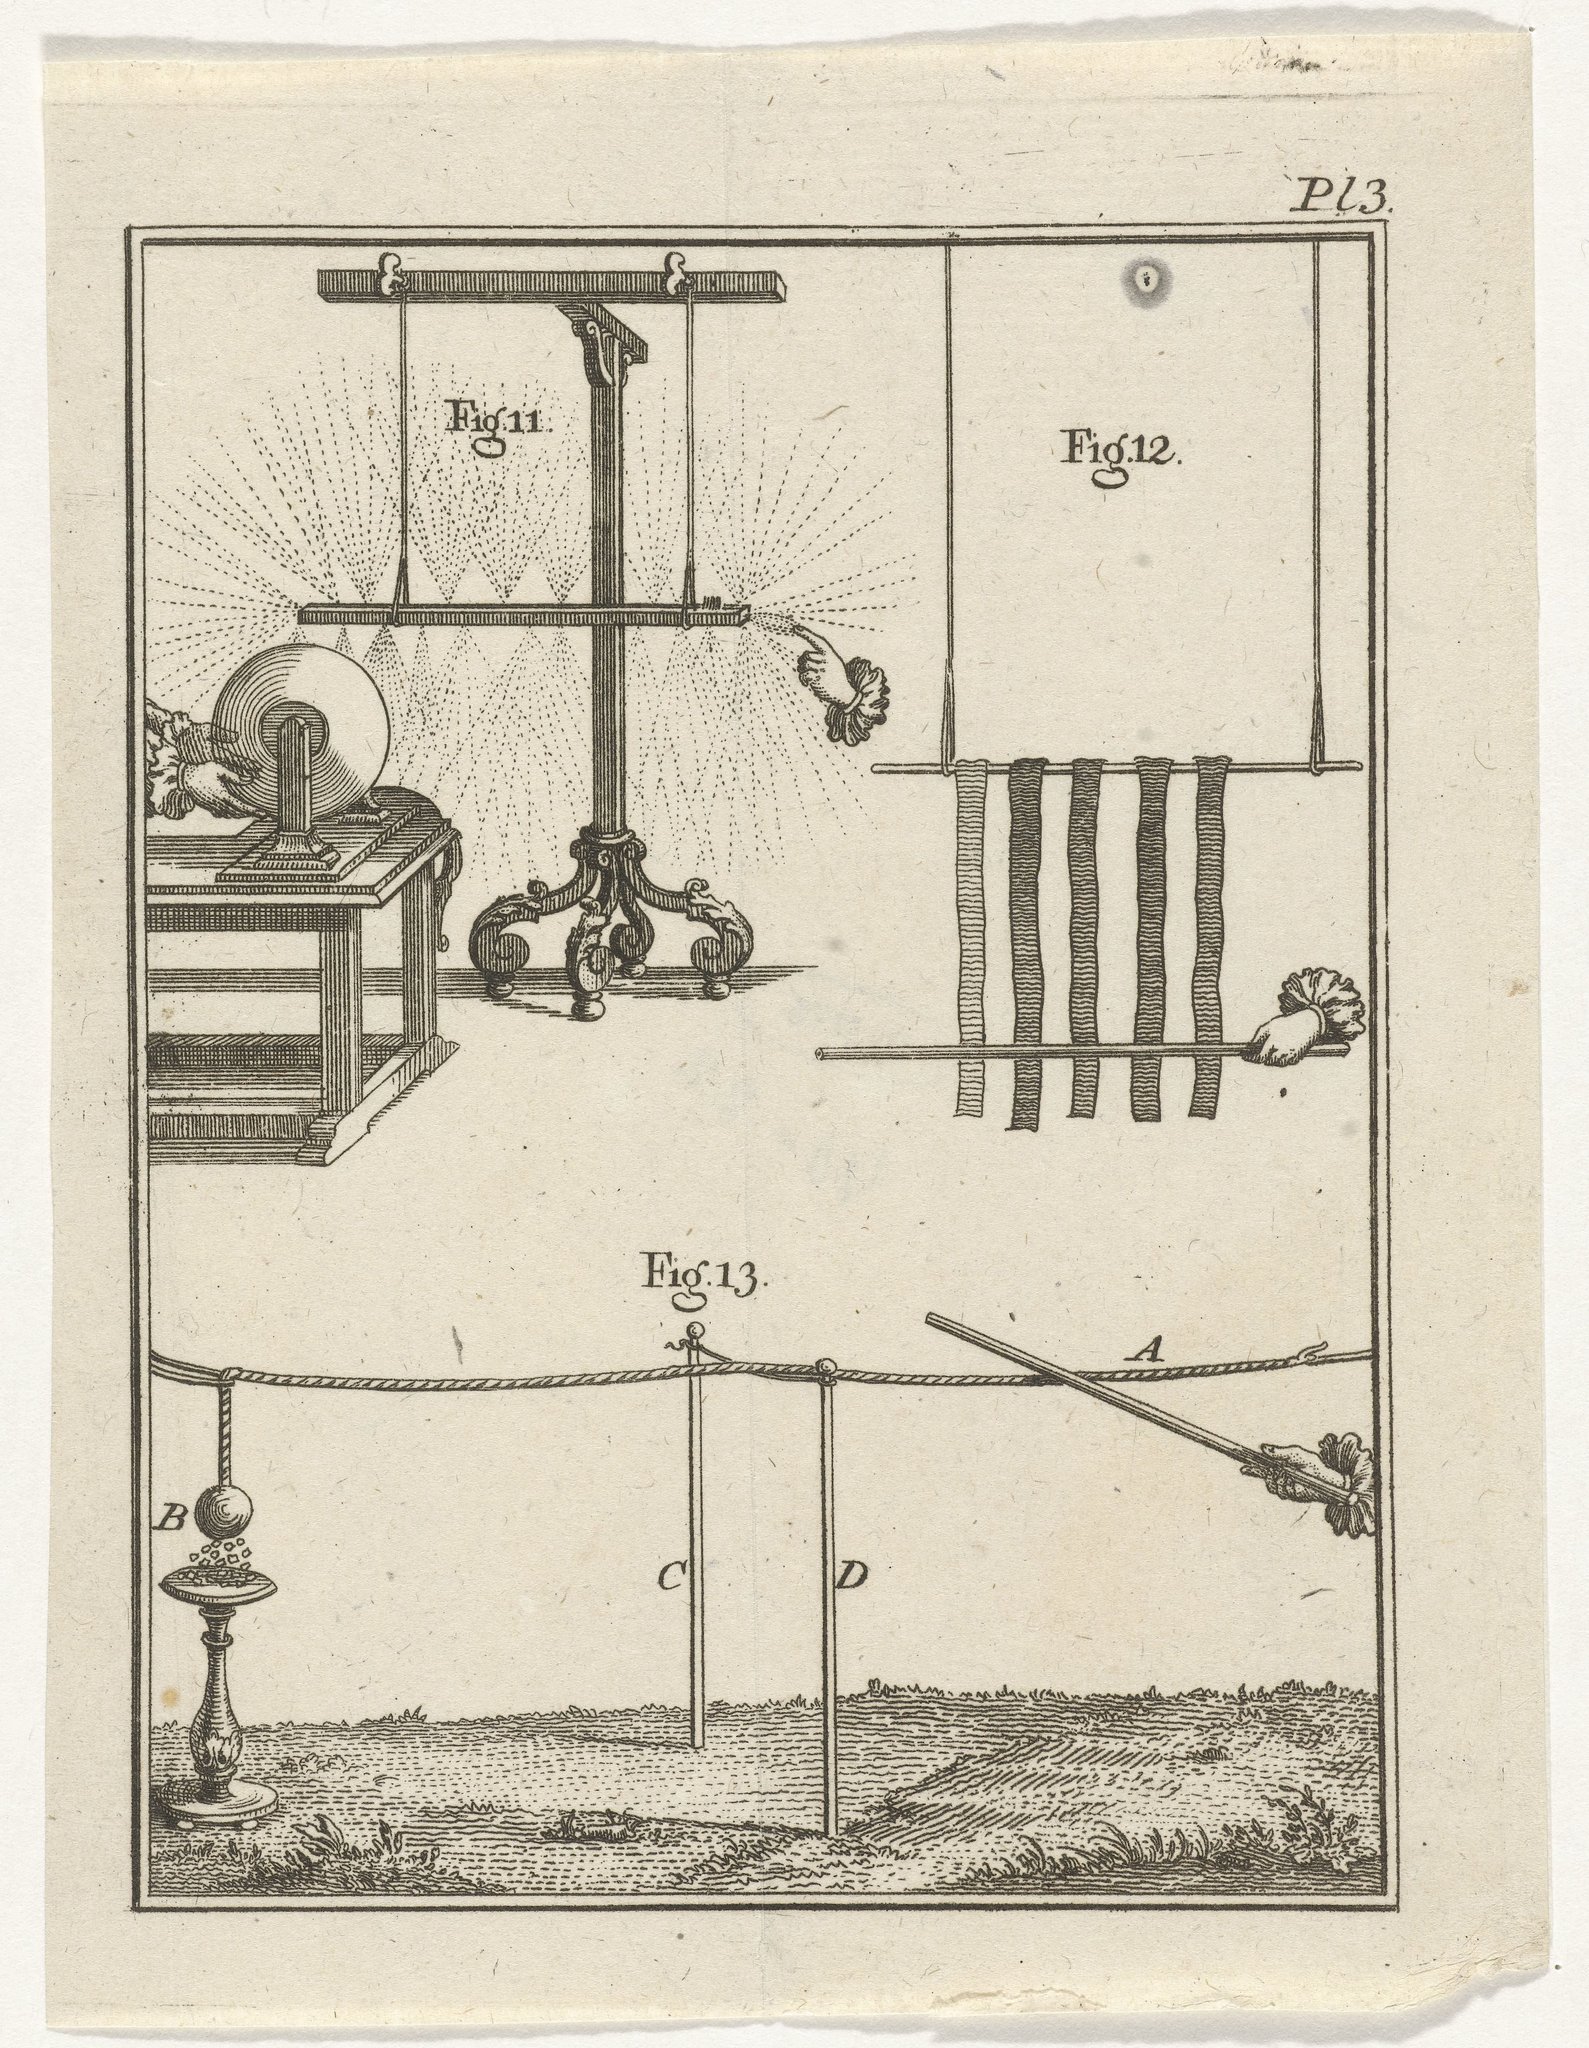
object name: print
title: Natuurkundige instrumenten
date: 1759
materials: paper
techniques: etching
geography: amsterdam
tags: physics (+ tools, instruments; laboratory equipment ~ scientific research)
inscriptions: collector's mark: Lugt 2228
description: Illustratie voor: Nollet, Jean Antoine. Natuurkundige lessen, door proefneemingen bevestigd, eerste deel. Amsterdam: Kornelis van Tongerlo, 1759.